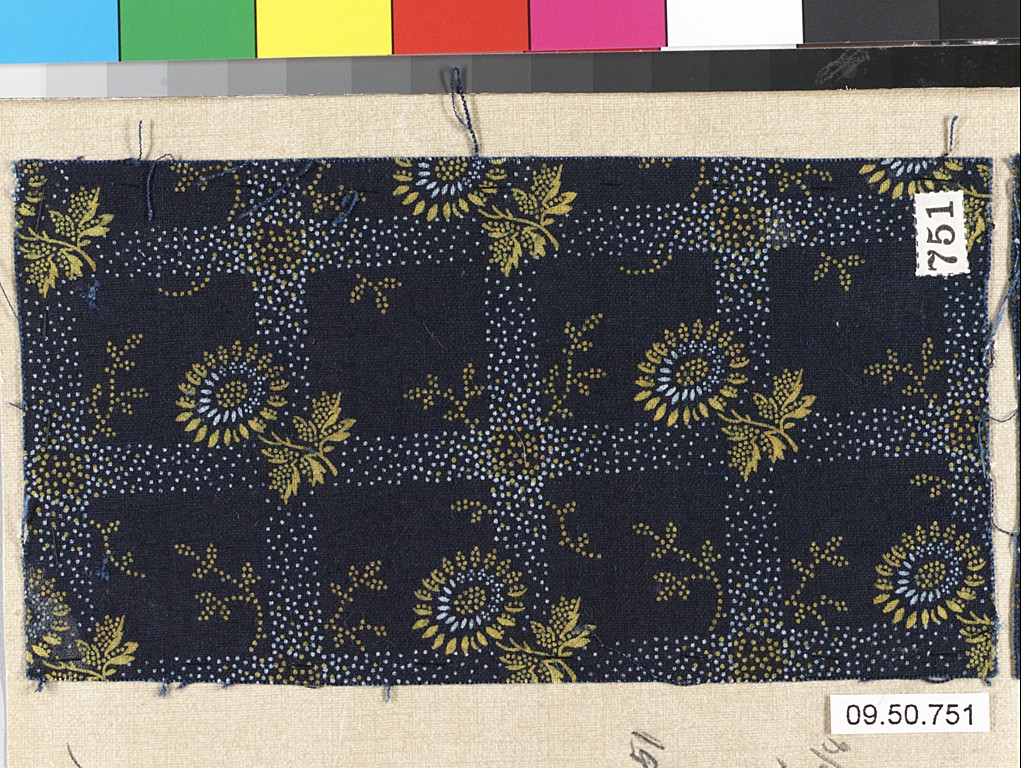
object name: piece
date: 1801-1900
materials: cotton